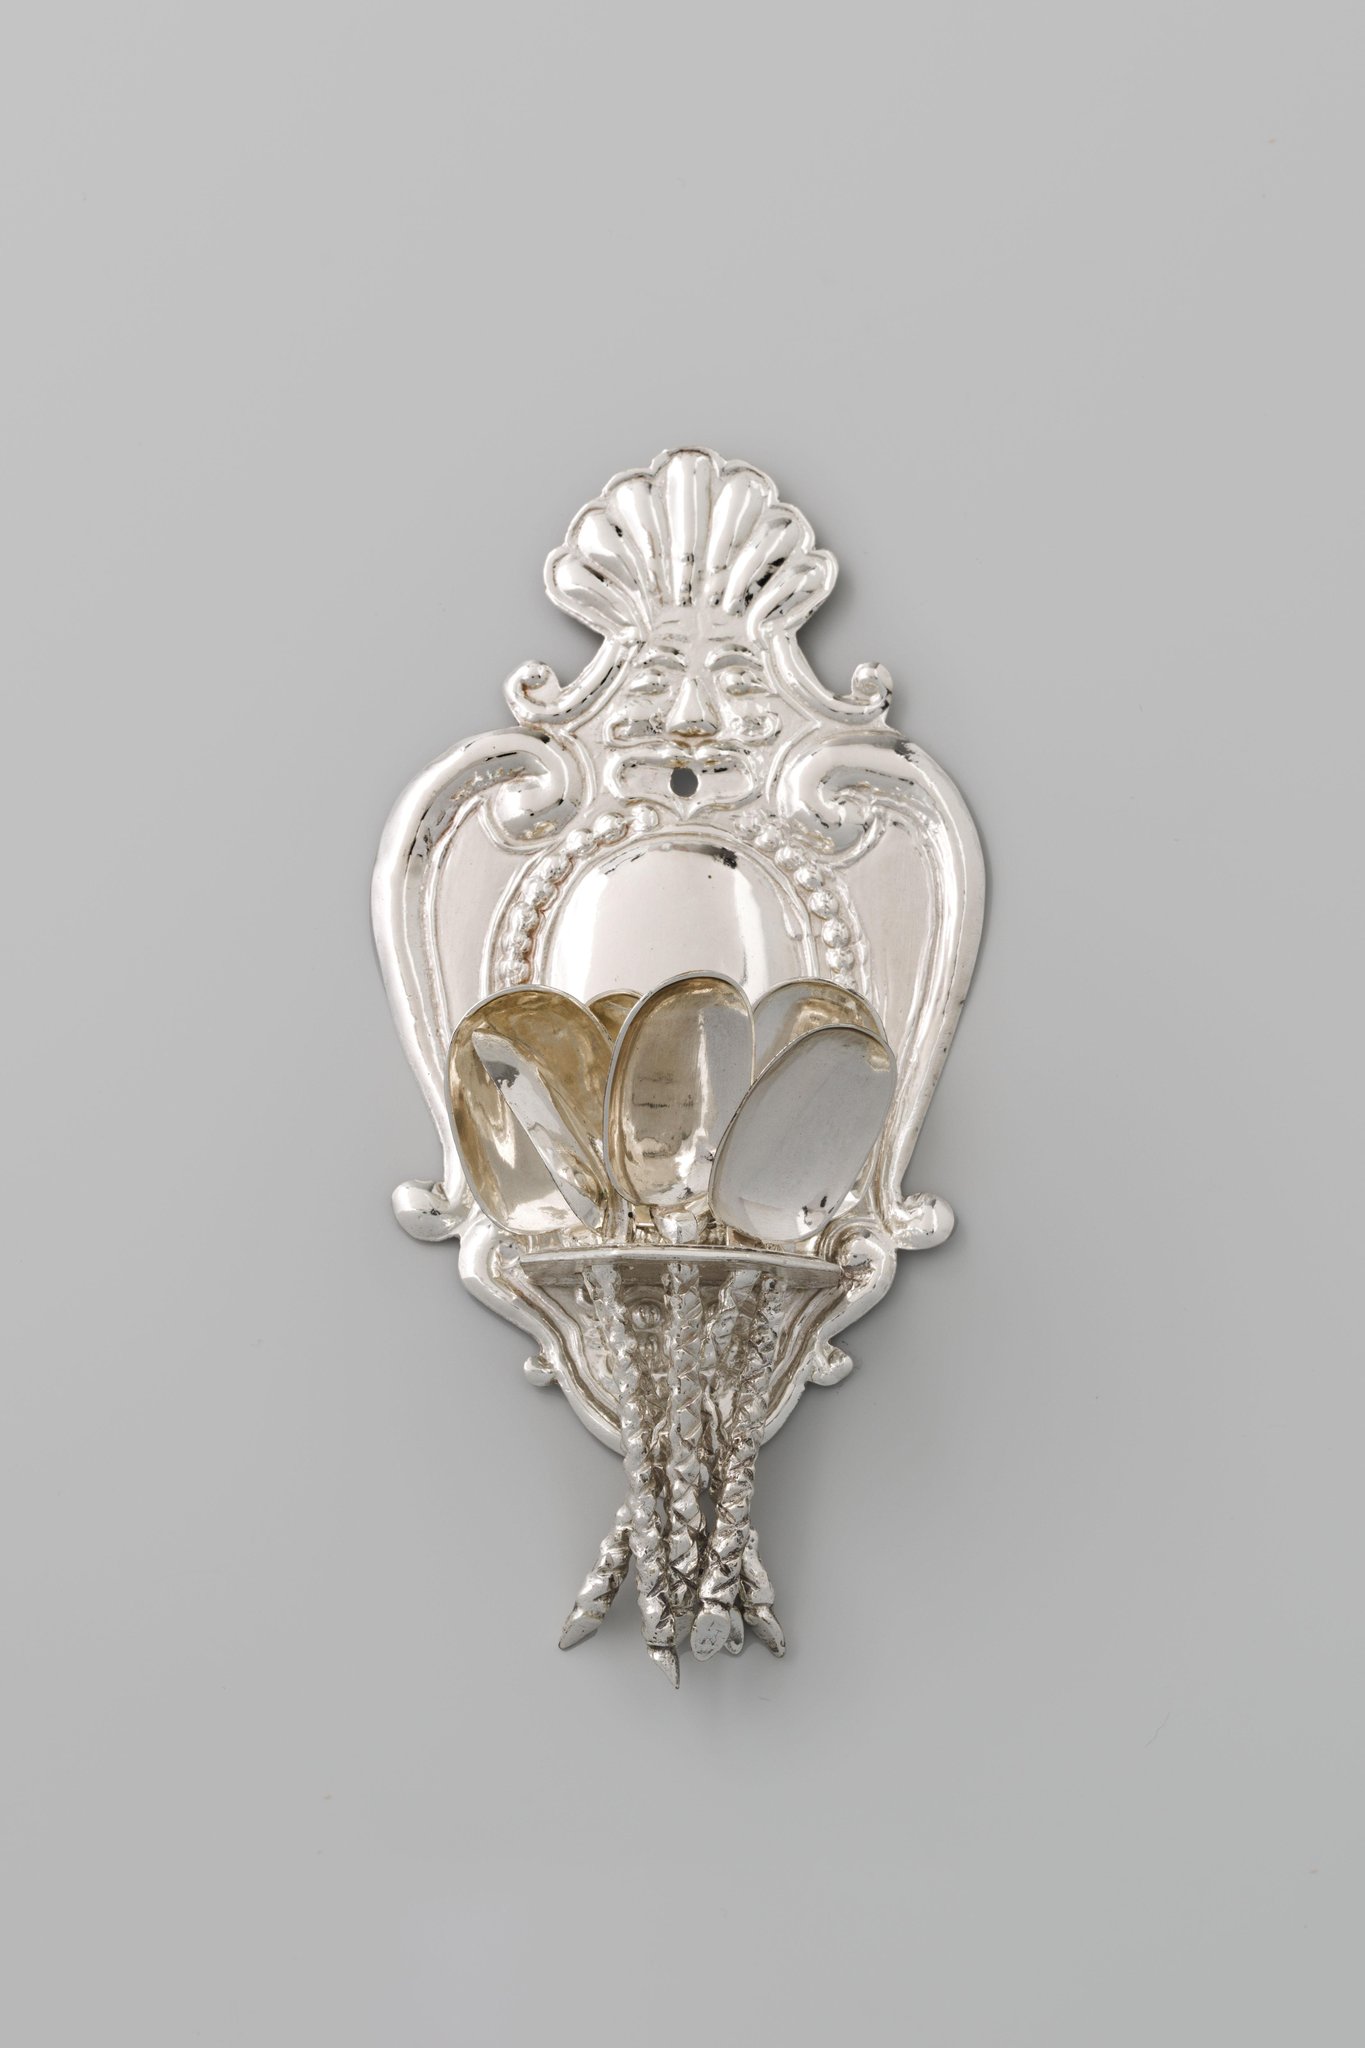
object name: miniature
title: Lepelrek met zes lepels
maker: wessel jansen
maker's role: silversmith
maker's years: -1696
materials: silver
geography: amsterdam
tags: spoon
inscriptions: maker's mark: ‘W (Citroen 1975, nr. 903)’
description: Lepelrek van zilver met zes lepels. Het rek is een veelhoekige plaat met gaten vastgezet op een achterschild in de vorm van een cartouche met schelpmotief, voluten, twee maskerons en parelrand (als een wandblaker). De lepels van zilver hebben een ovale bak, rechte geribbelde steel en naaldvormig lof.